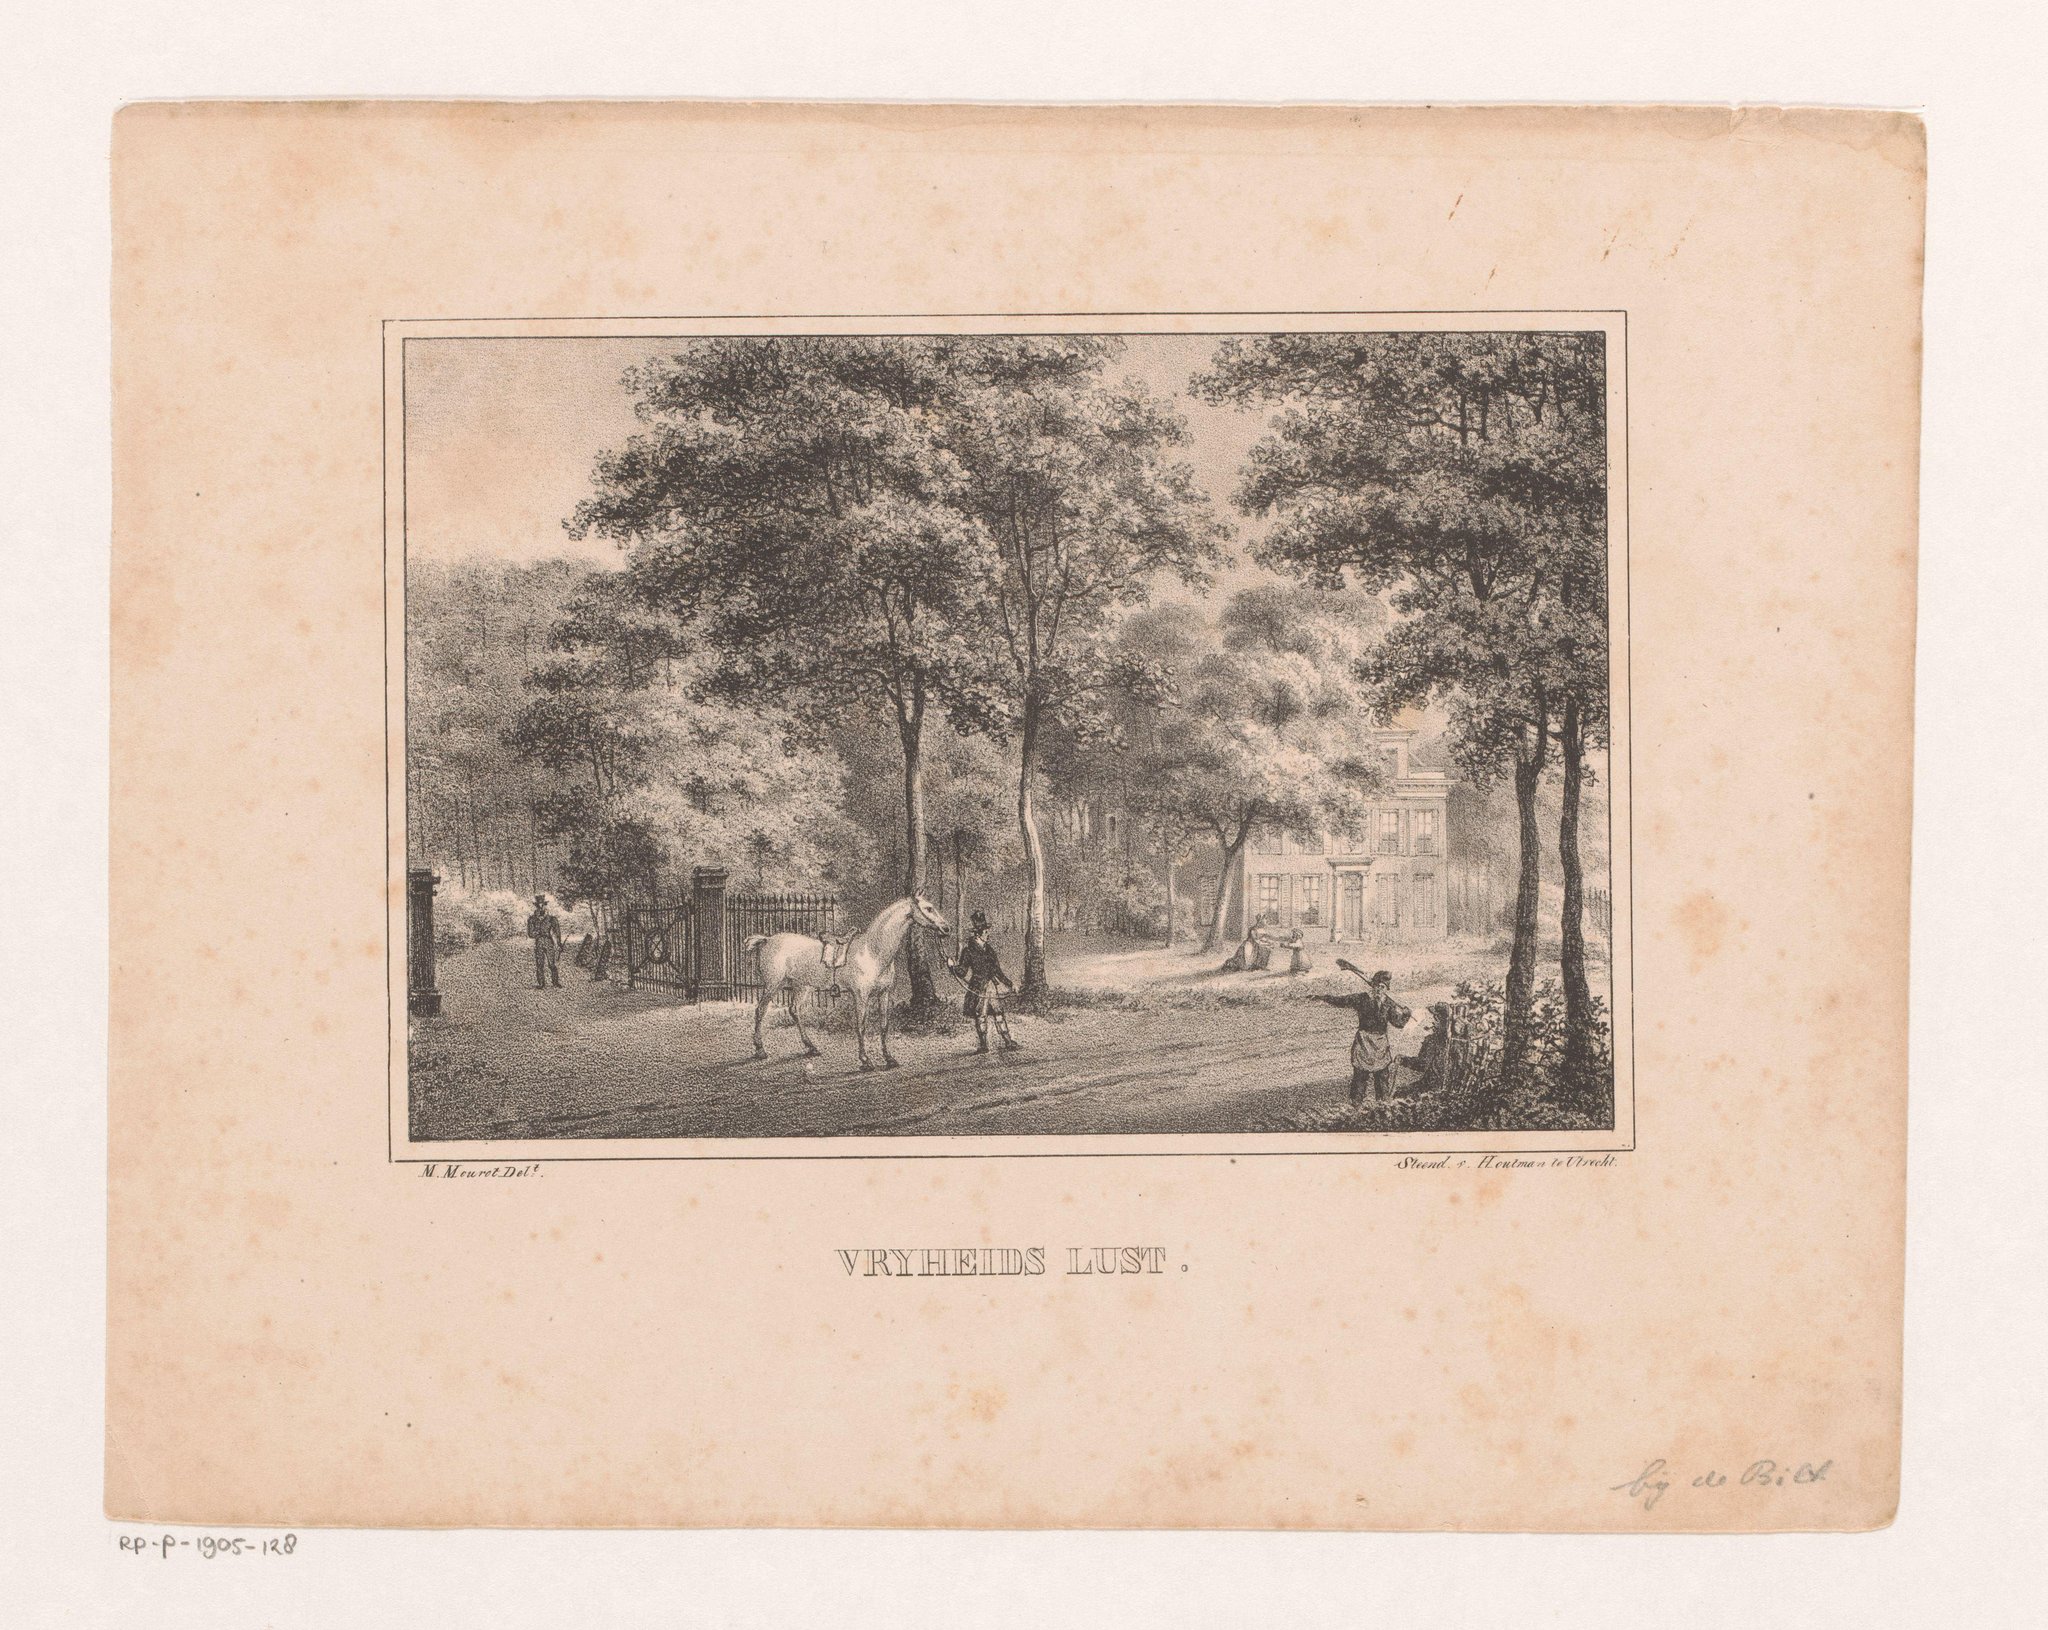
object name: print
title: Gezicht p buitenplaats Vrijheidslust bij de Bilt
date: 1829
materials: paper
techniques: lithograph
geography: utrecht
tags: leading a horse by the reins; rider beside his horse, country-house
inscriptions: collector's mark: Lugt 2228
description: Uitgegeven in: Gezigten van buitenplaatsen en gebouwen gelegen tusschen de Stad Utrecht en de Grebbe. Utrecht, I. P. Houtman: 1829.